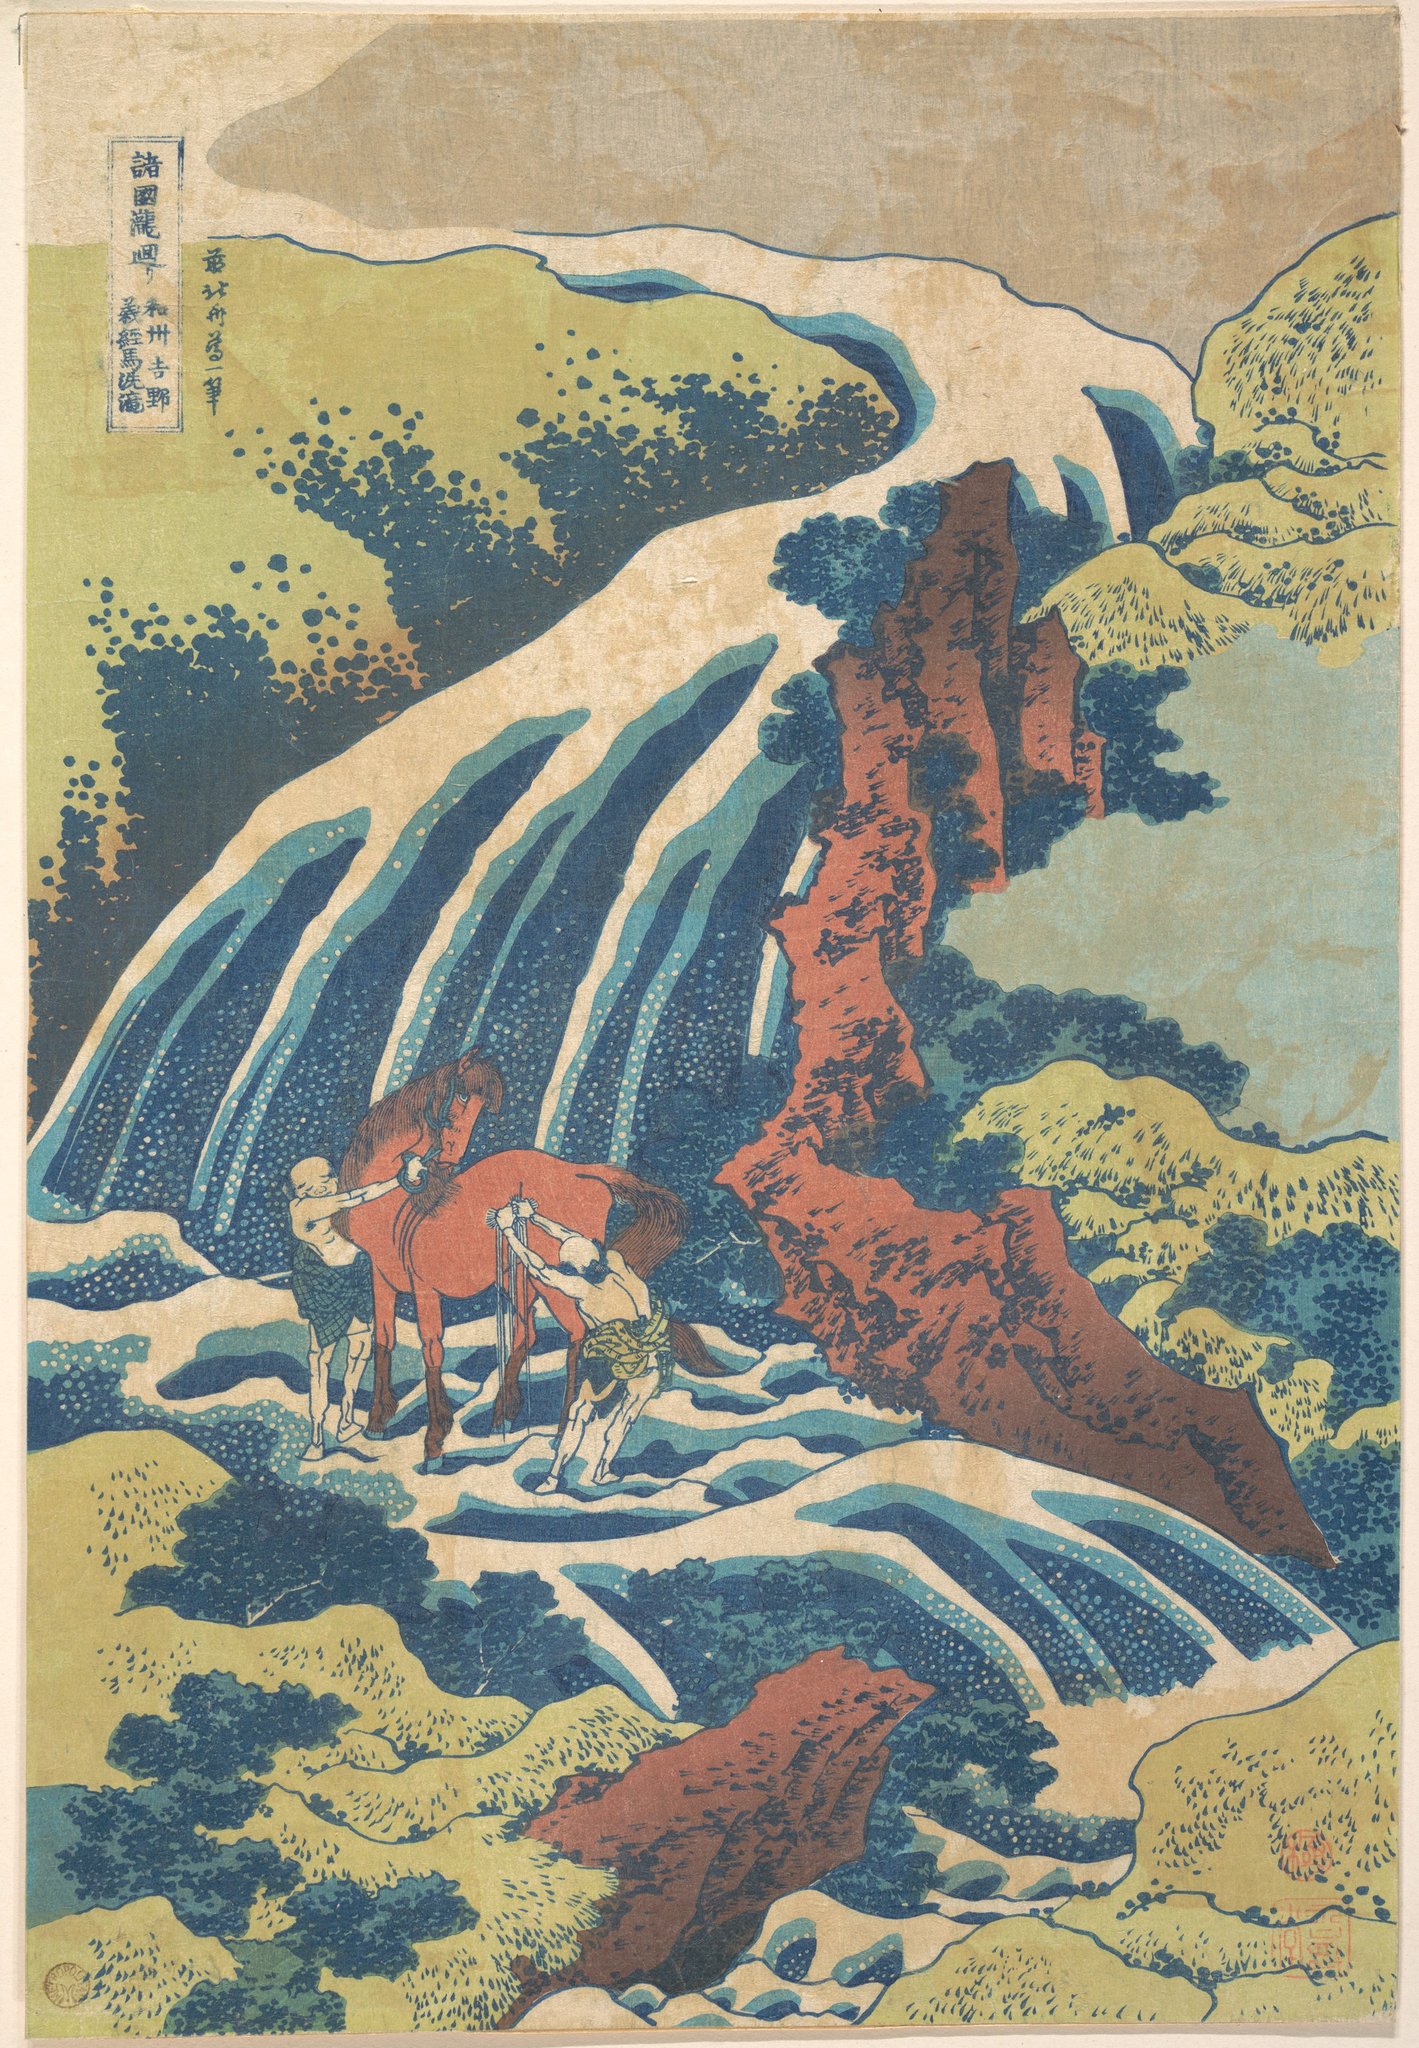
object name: woodblock print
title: The Waterfall Where Yoshitsune Washed His Horse at Yoshino in Yamato Province (Washū Yoshino Yoshitsune uma arai no taki), from the series A Tour of Waterfalls in Various Provinces (Shokoku taki meguri)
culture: japanese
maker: katsushika hokusai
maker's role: artist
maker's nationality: japanese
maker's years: 1760-1849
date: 1832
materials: ink, paper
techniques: woodblock print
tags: men,horses,waterfalls,washing